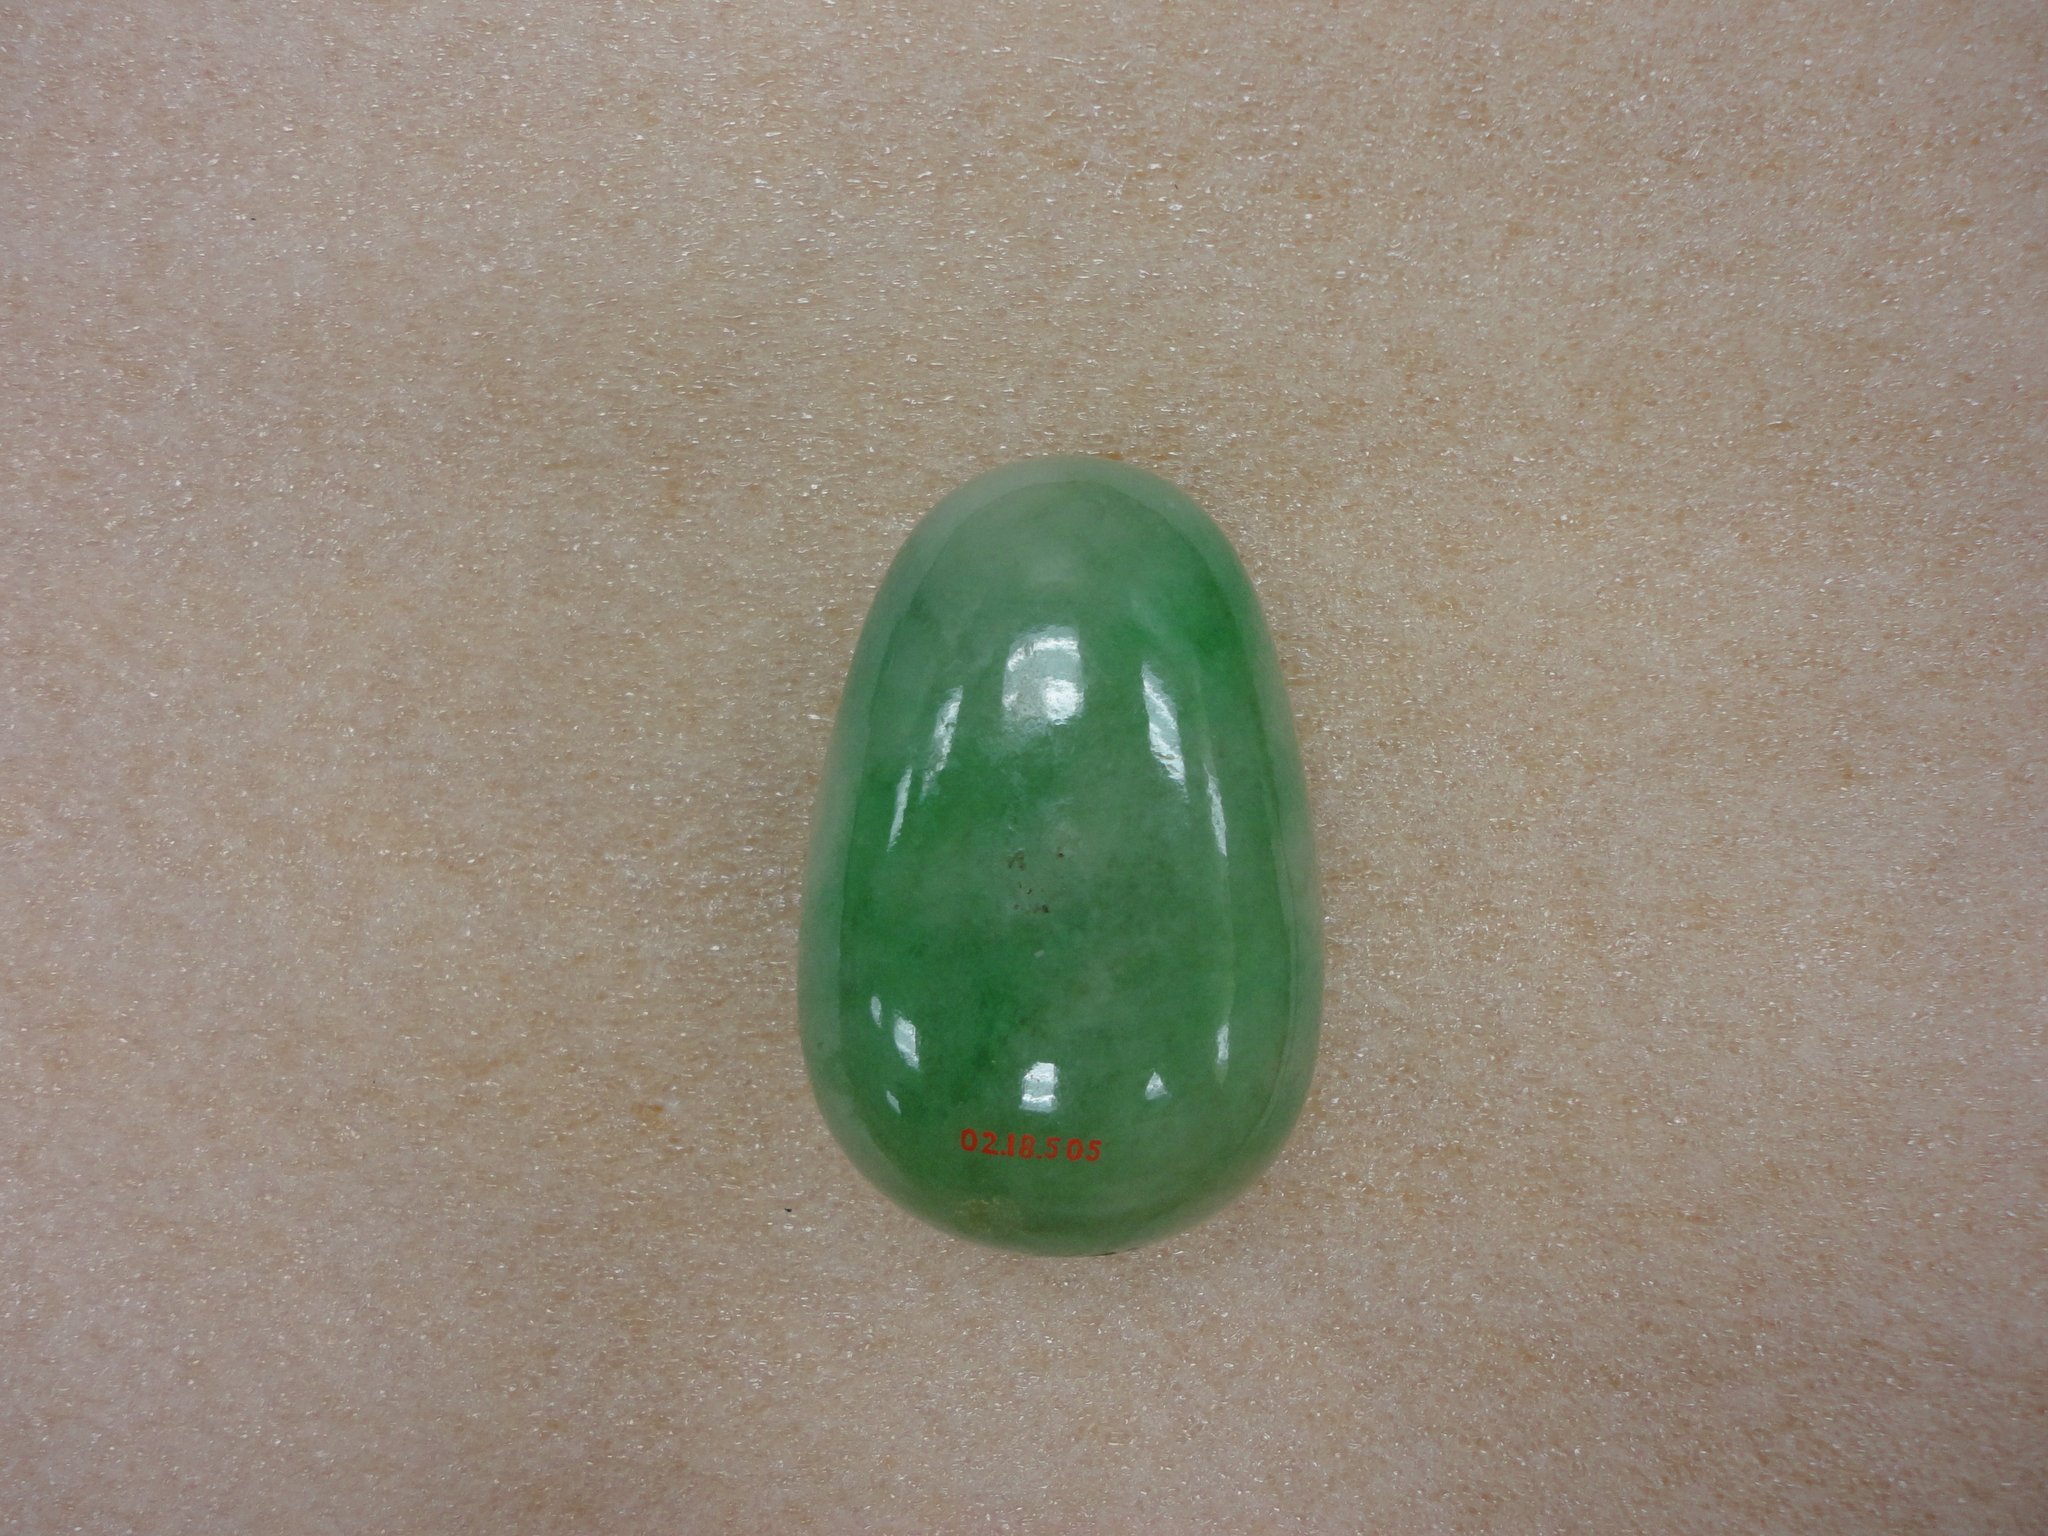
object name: snuff bottle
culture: chinese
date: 1736-1795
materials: jade